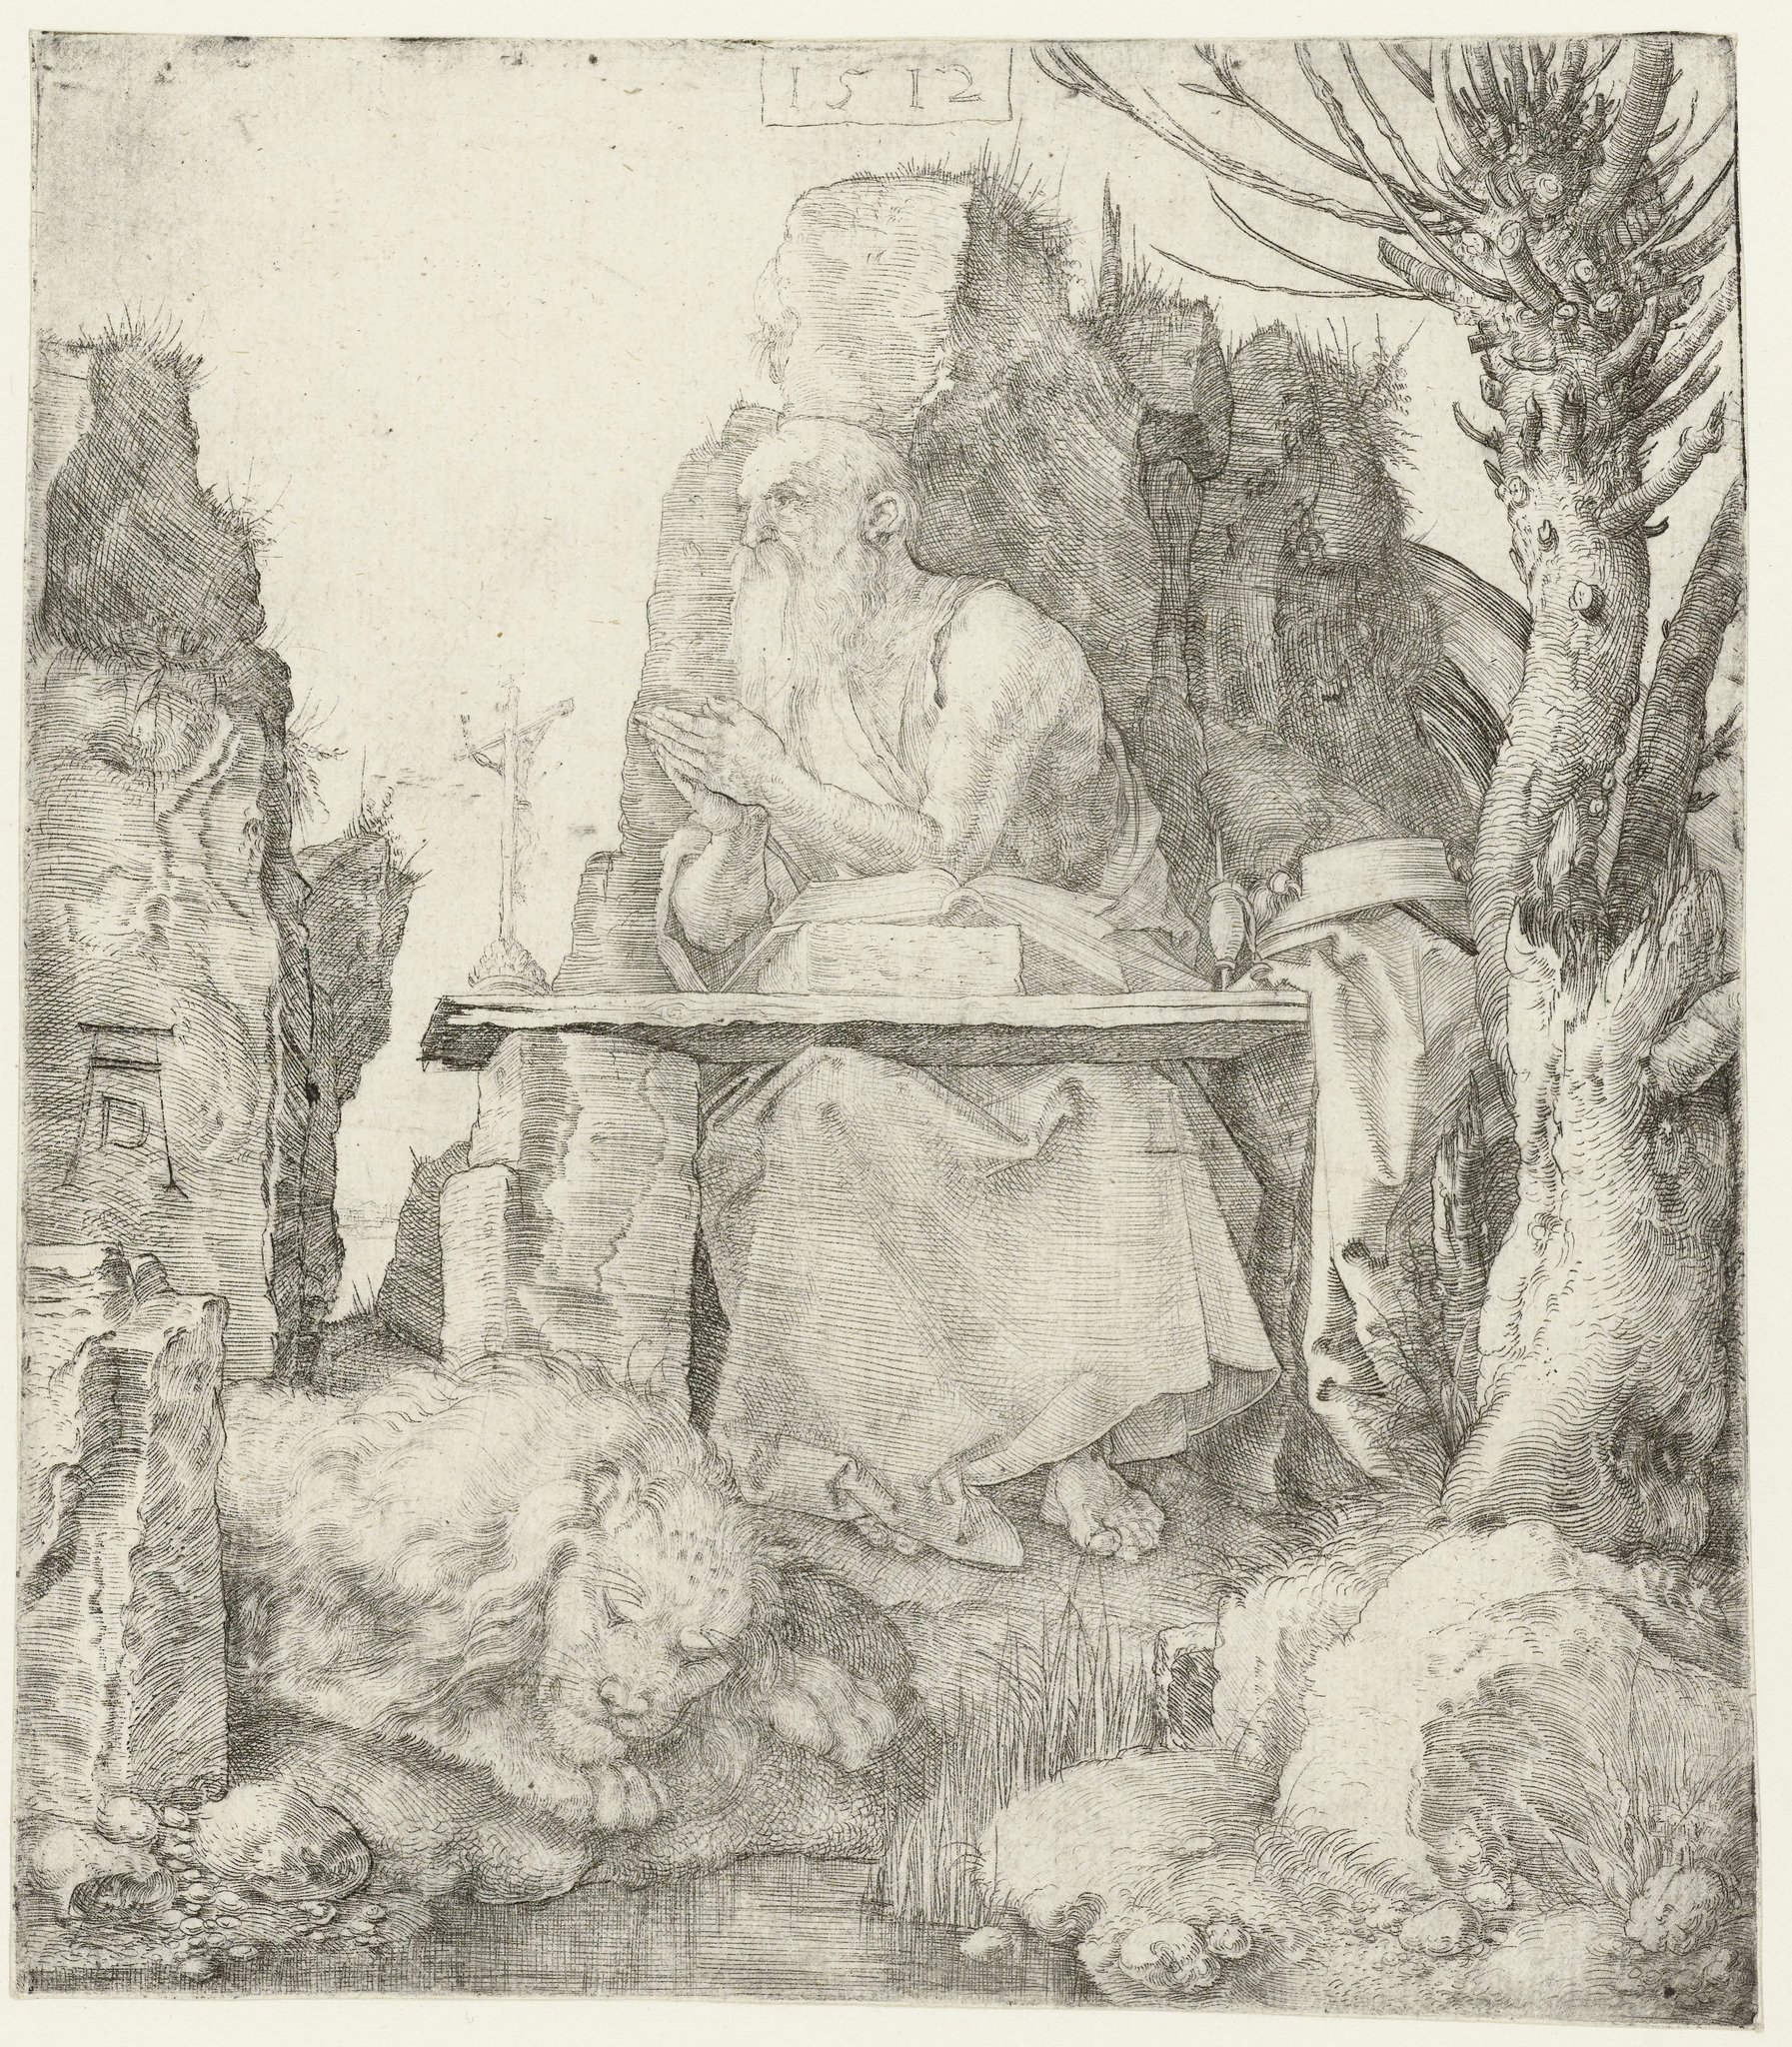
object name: print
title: De Heilige Hiëronymus in de wildernis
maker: albrecht dürer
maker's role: draughtsman, painter, print maker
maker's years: 1471-1528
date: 1512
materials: paper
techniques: drypoint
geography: nuremberg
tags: st. jerome as penitent in the desert, half naked, kneeling before a crucifix and holding a stone in his hand to beat his breast; a skull (and other 'vanitas' symbols), sometimes a scorpion and a snake beside him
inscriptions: collector's mark: Lugt 2228a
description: De Heilige Hiëronymus zit in een rotsachtige omgeving te bidden bij een crucifix. Naast hem staat een knotwilg, aan zijn voeten ligt een leeuw.